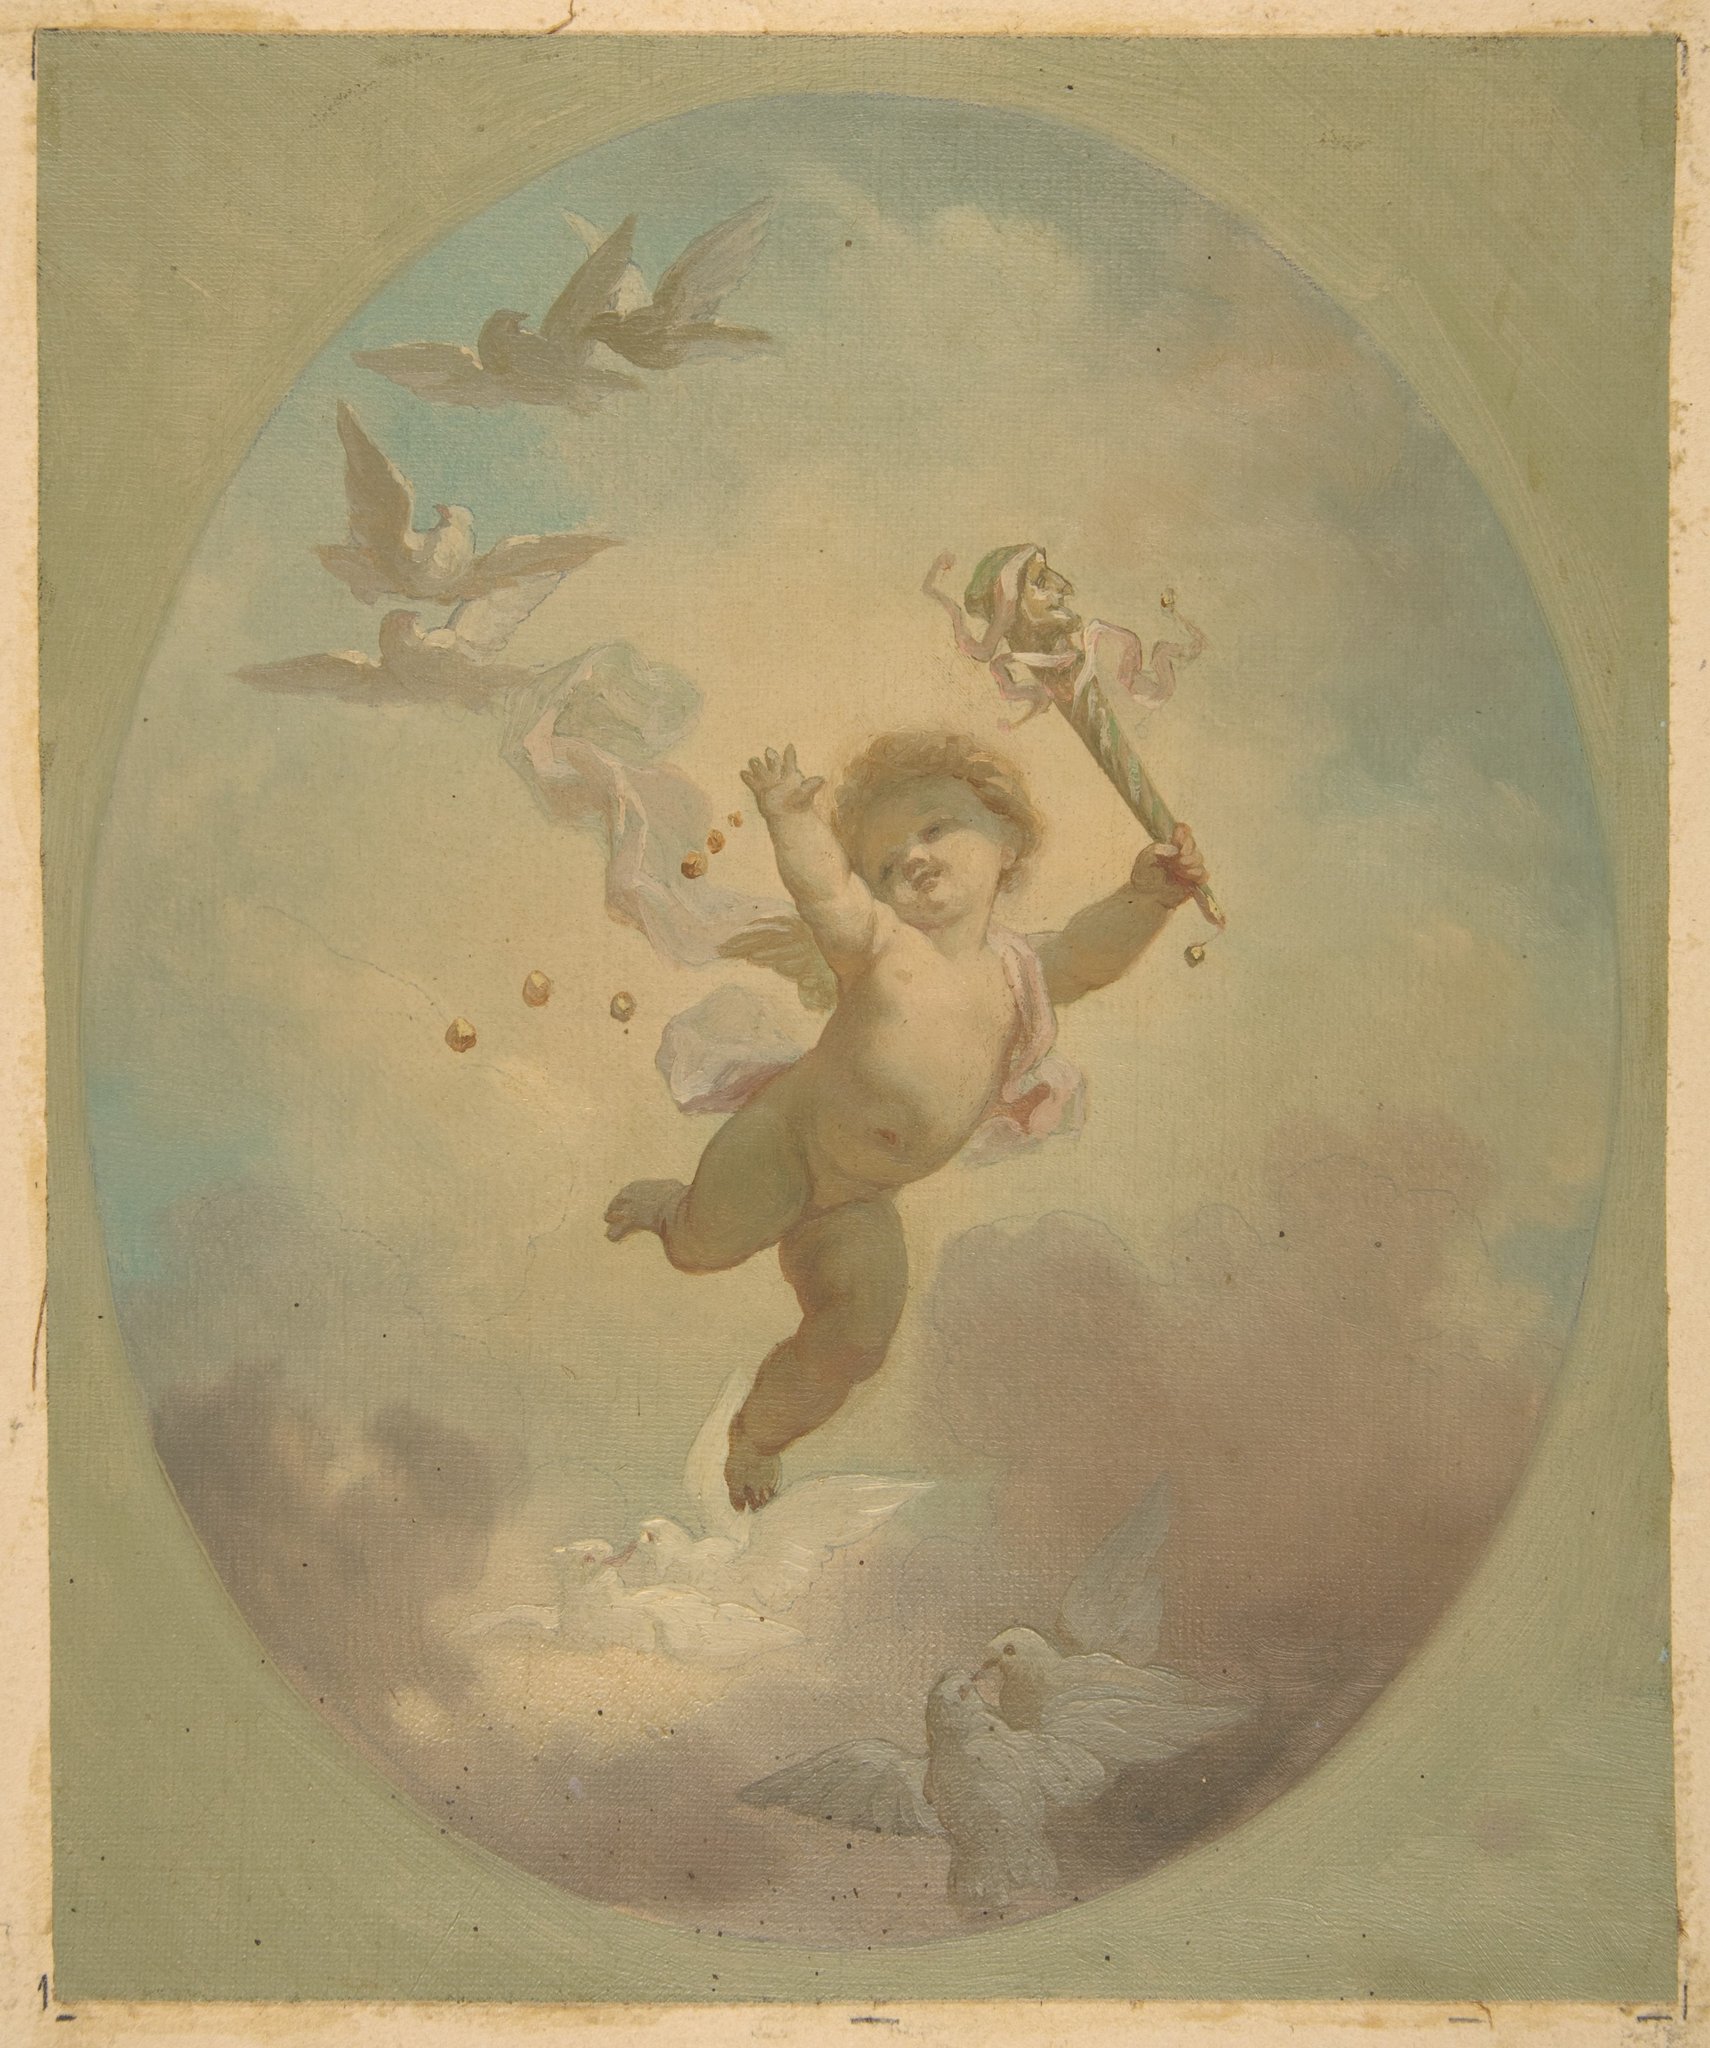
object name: drawing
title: A winged putto and turtle doves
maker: jules-edmond-charles lachaise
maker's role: artist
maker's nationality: french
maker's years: 1897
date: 1851-1900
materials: canvas, oil, paper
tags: doves,putti